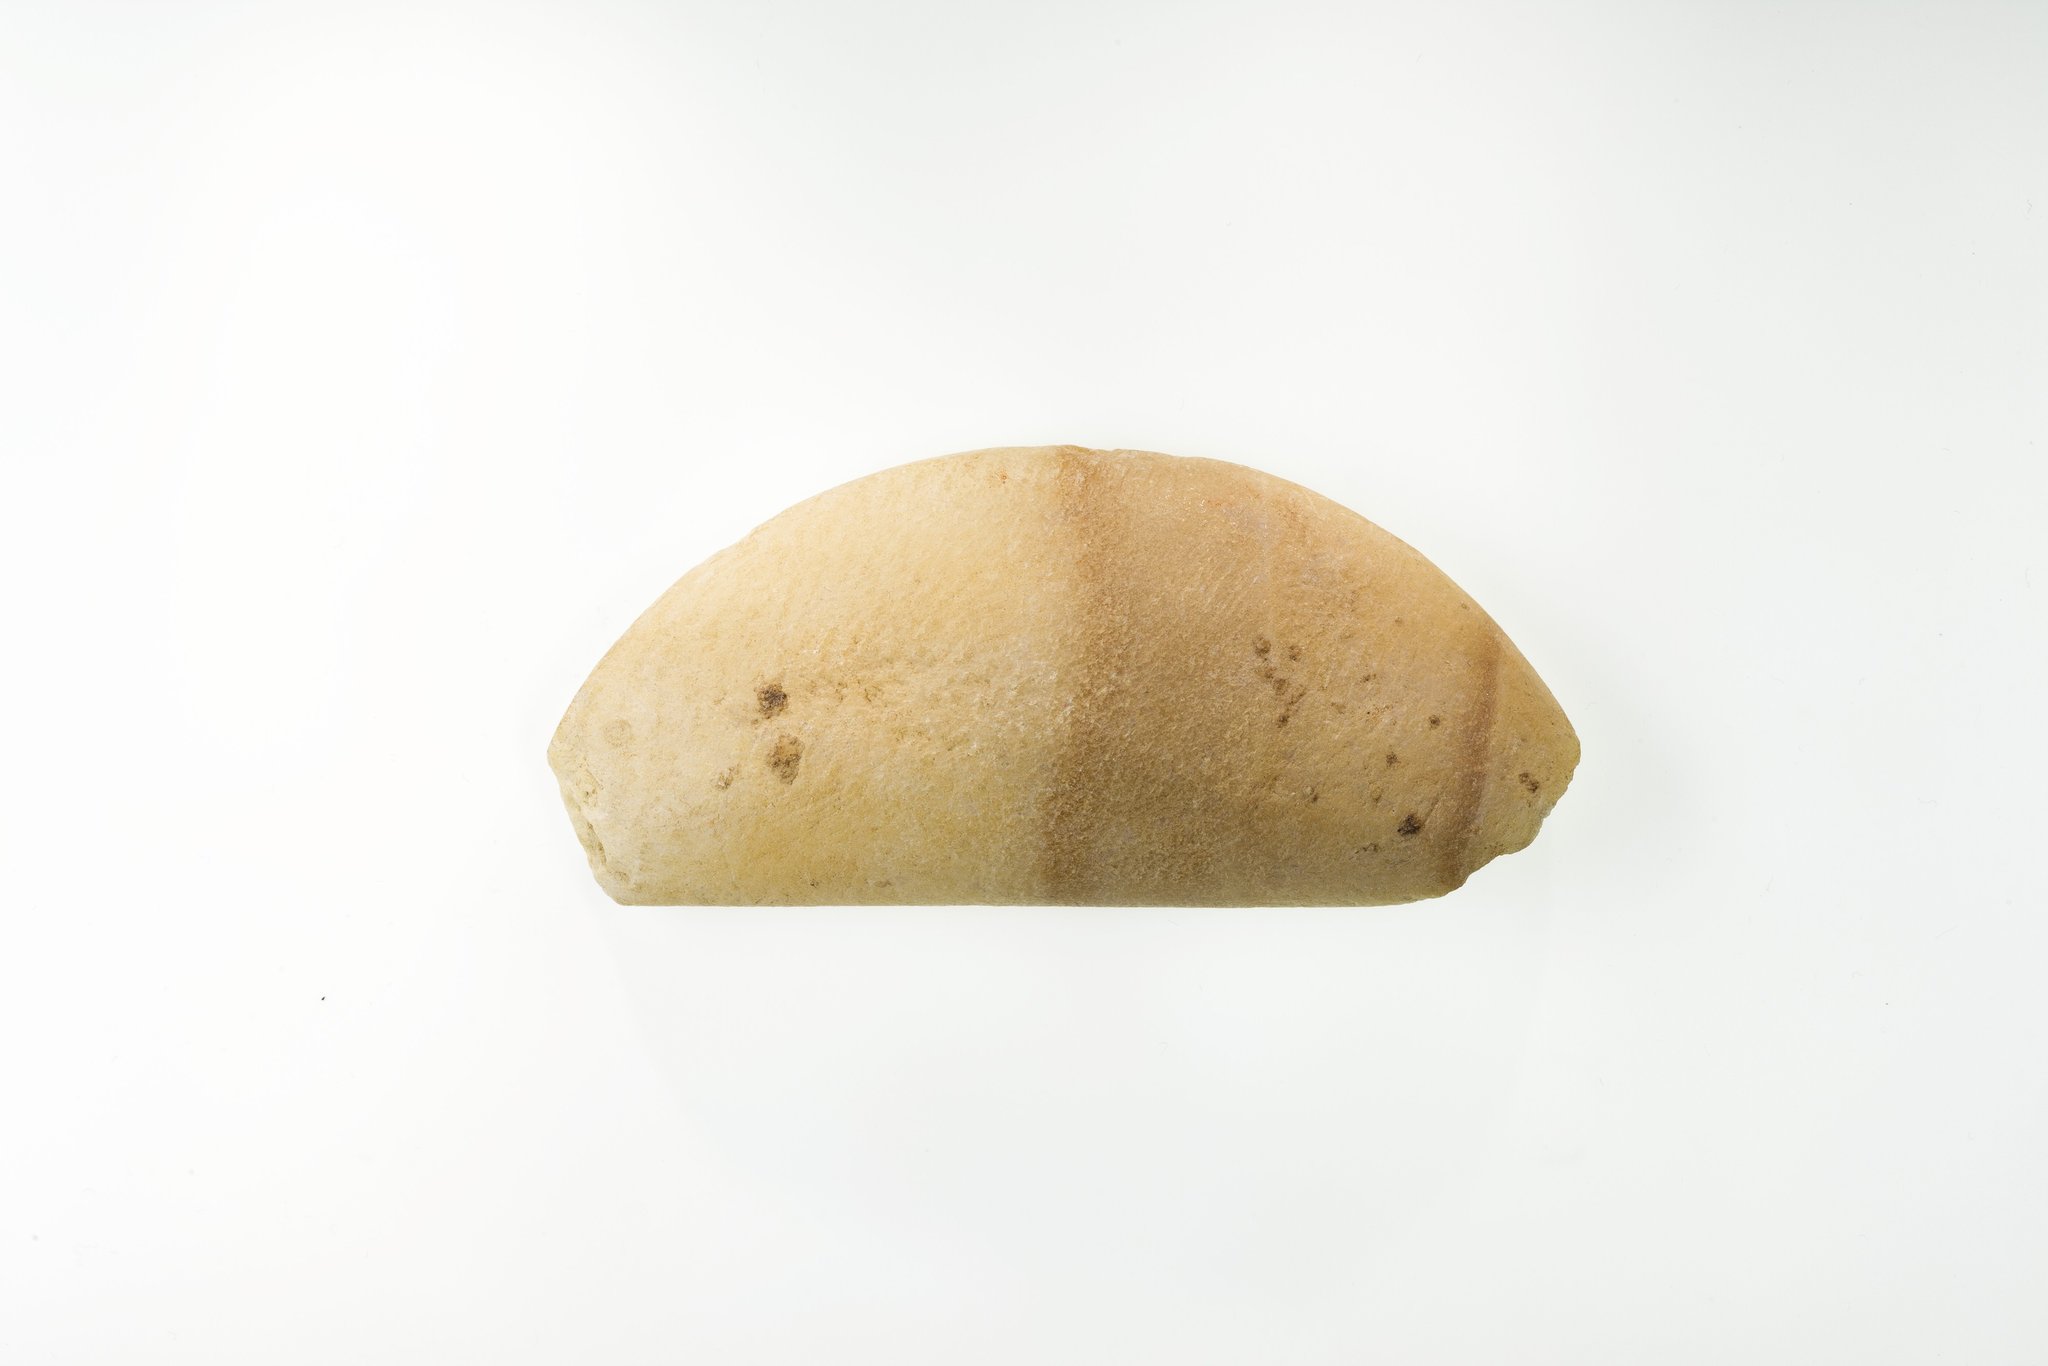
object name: alabaster plaque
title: Plaque of alabaster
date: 1981-1640 BCE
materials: stone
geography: egypt